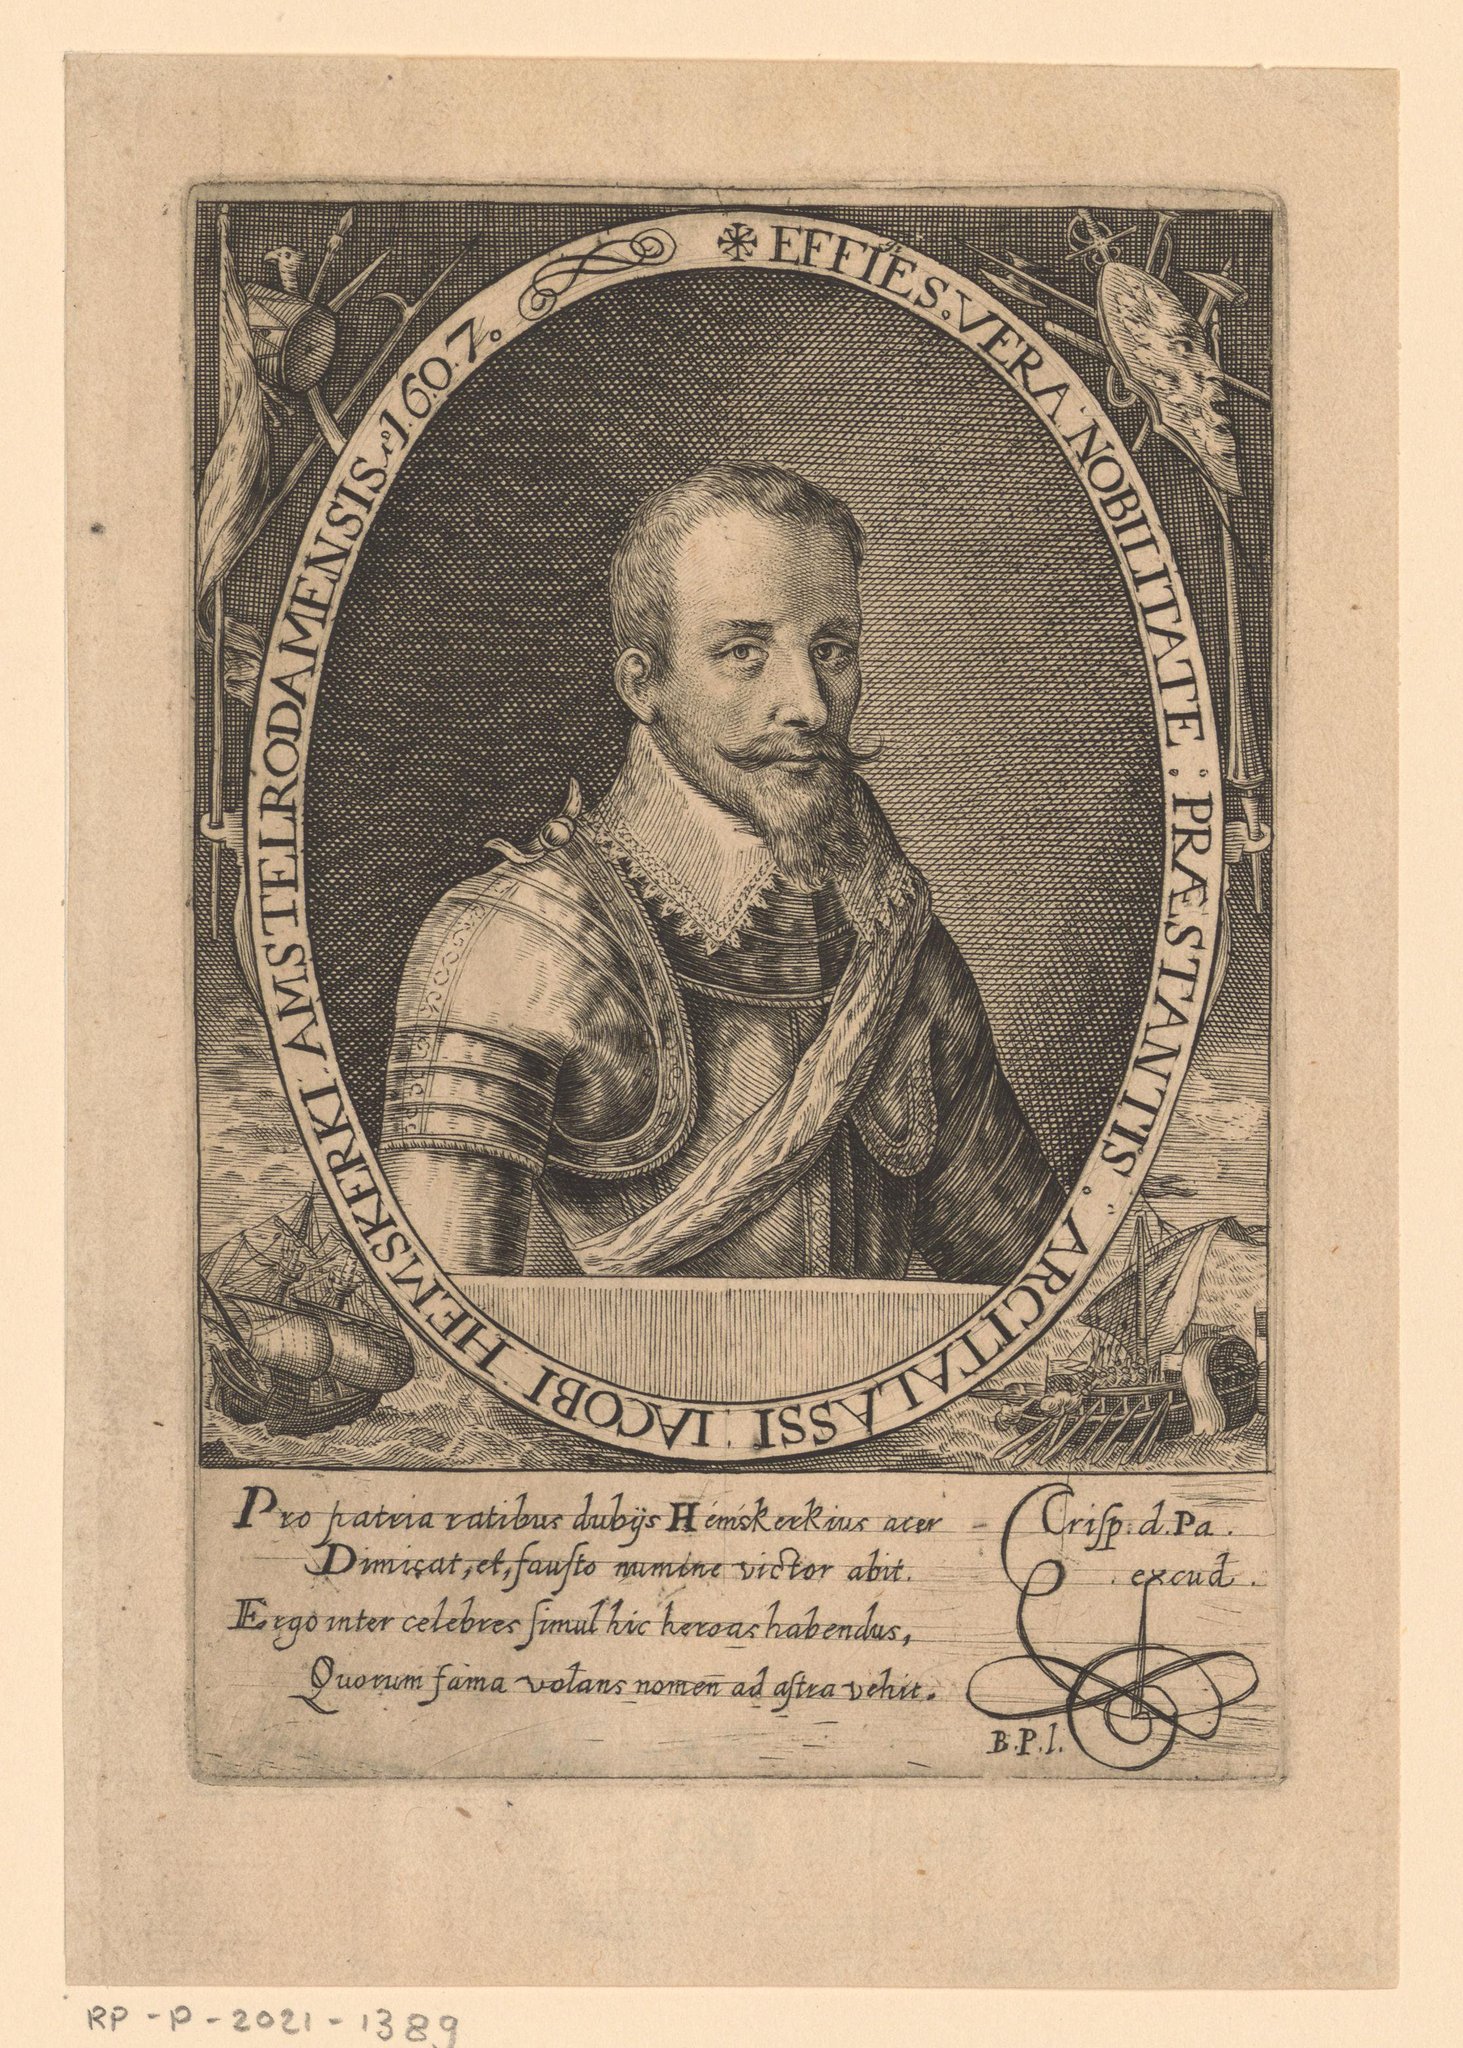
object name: print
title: Portret van Jacob van Heemskerck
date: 1607-1637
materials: paper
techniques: engraving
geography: cologne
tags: amsterdam, jacob van heemskerck, armour, battle (+ naval force), historical persons, commander-in-chief, admiral